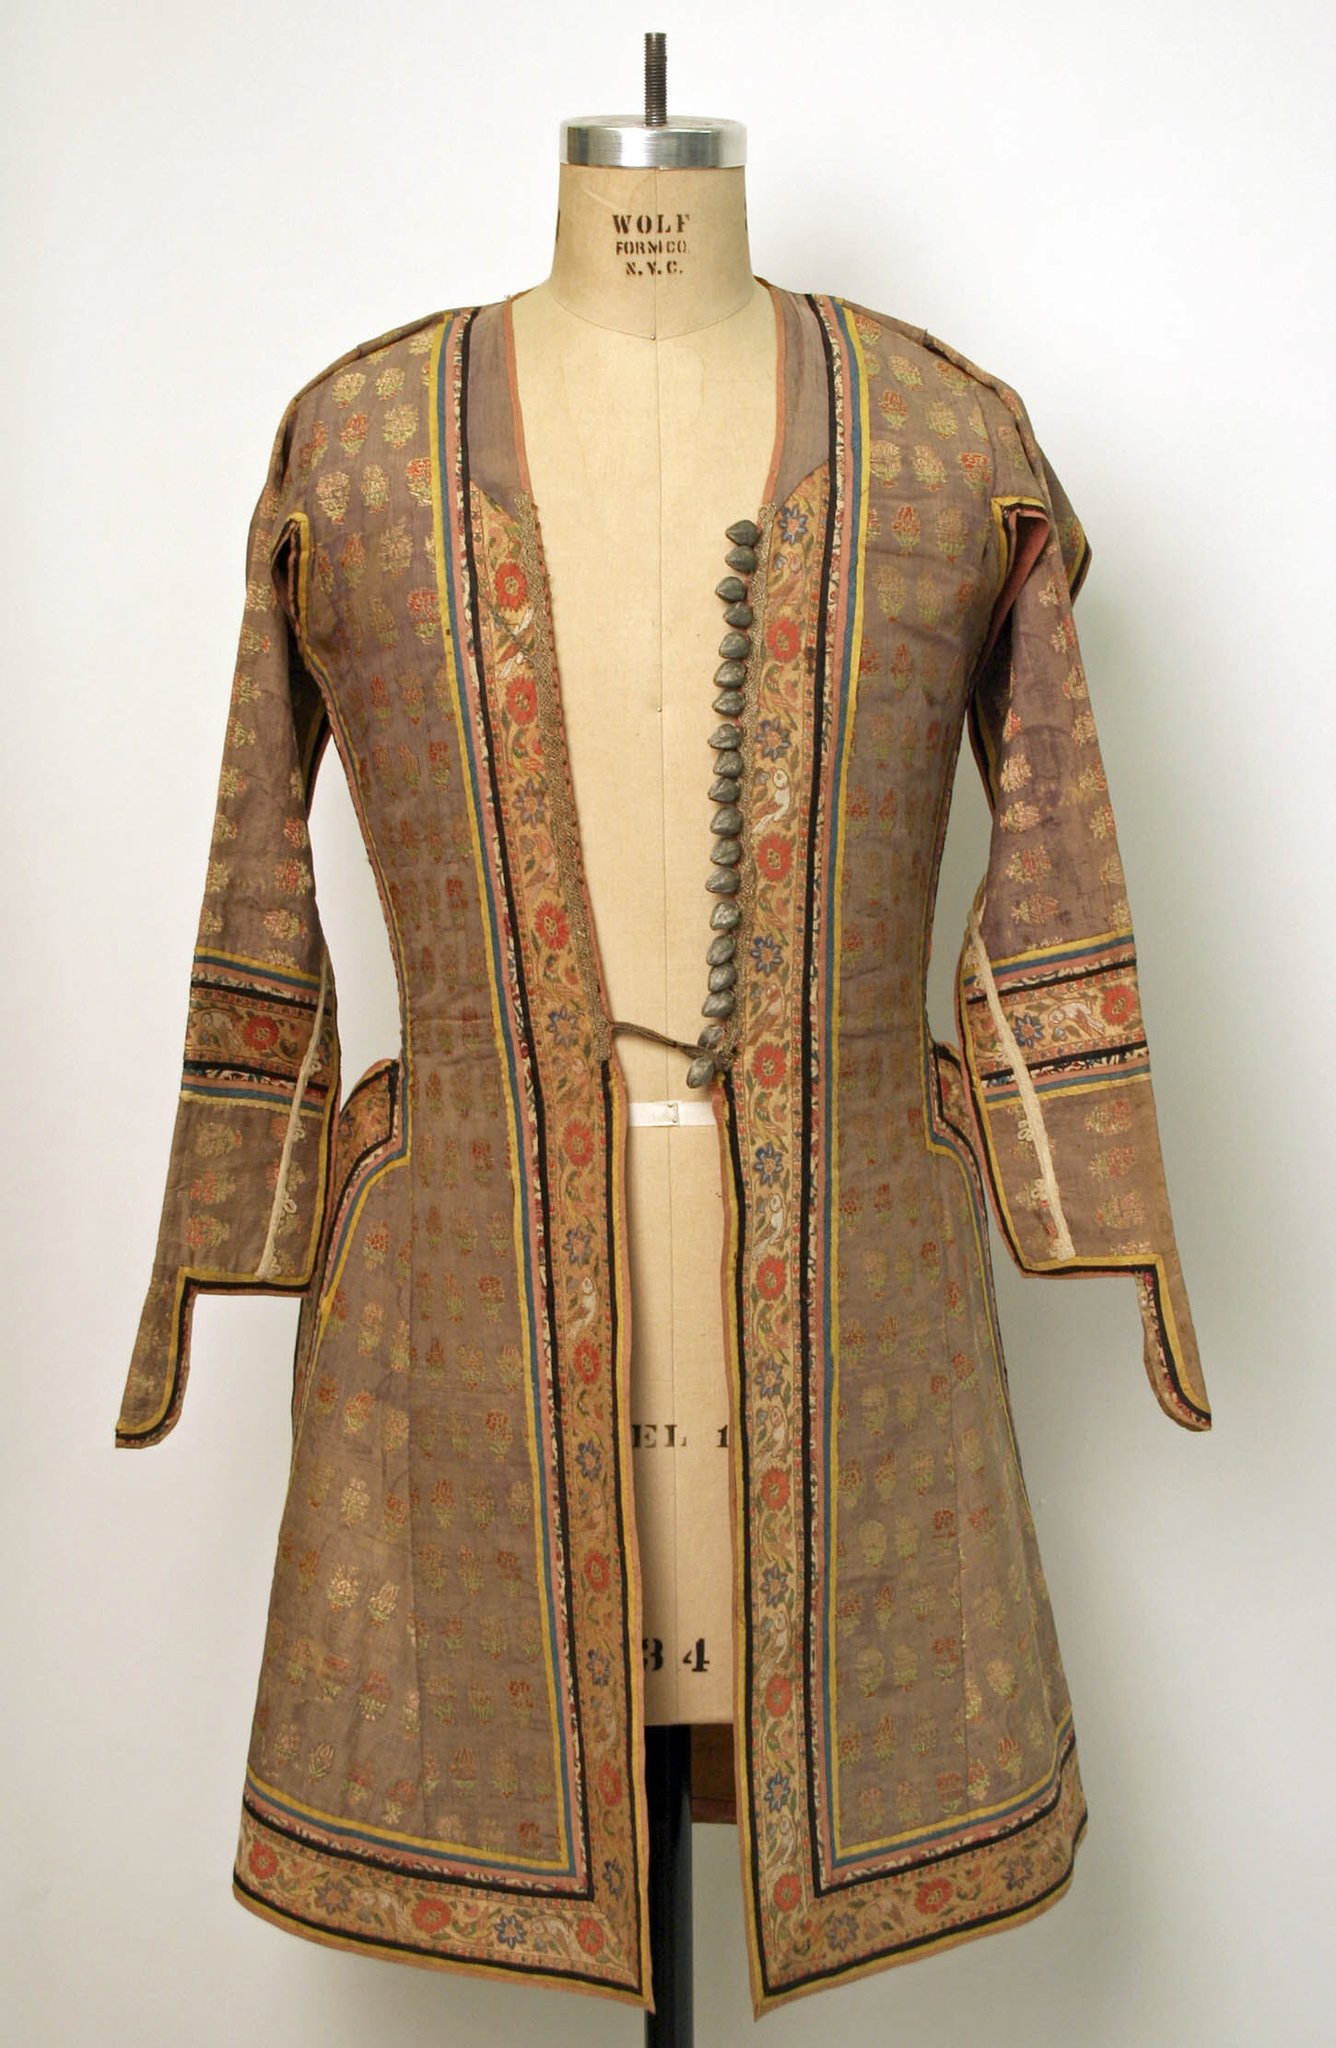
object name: coat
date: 1701-1800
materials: cotton, metal thread, silk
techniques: brocade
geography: iran